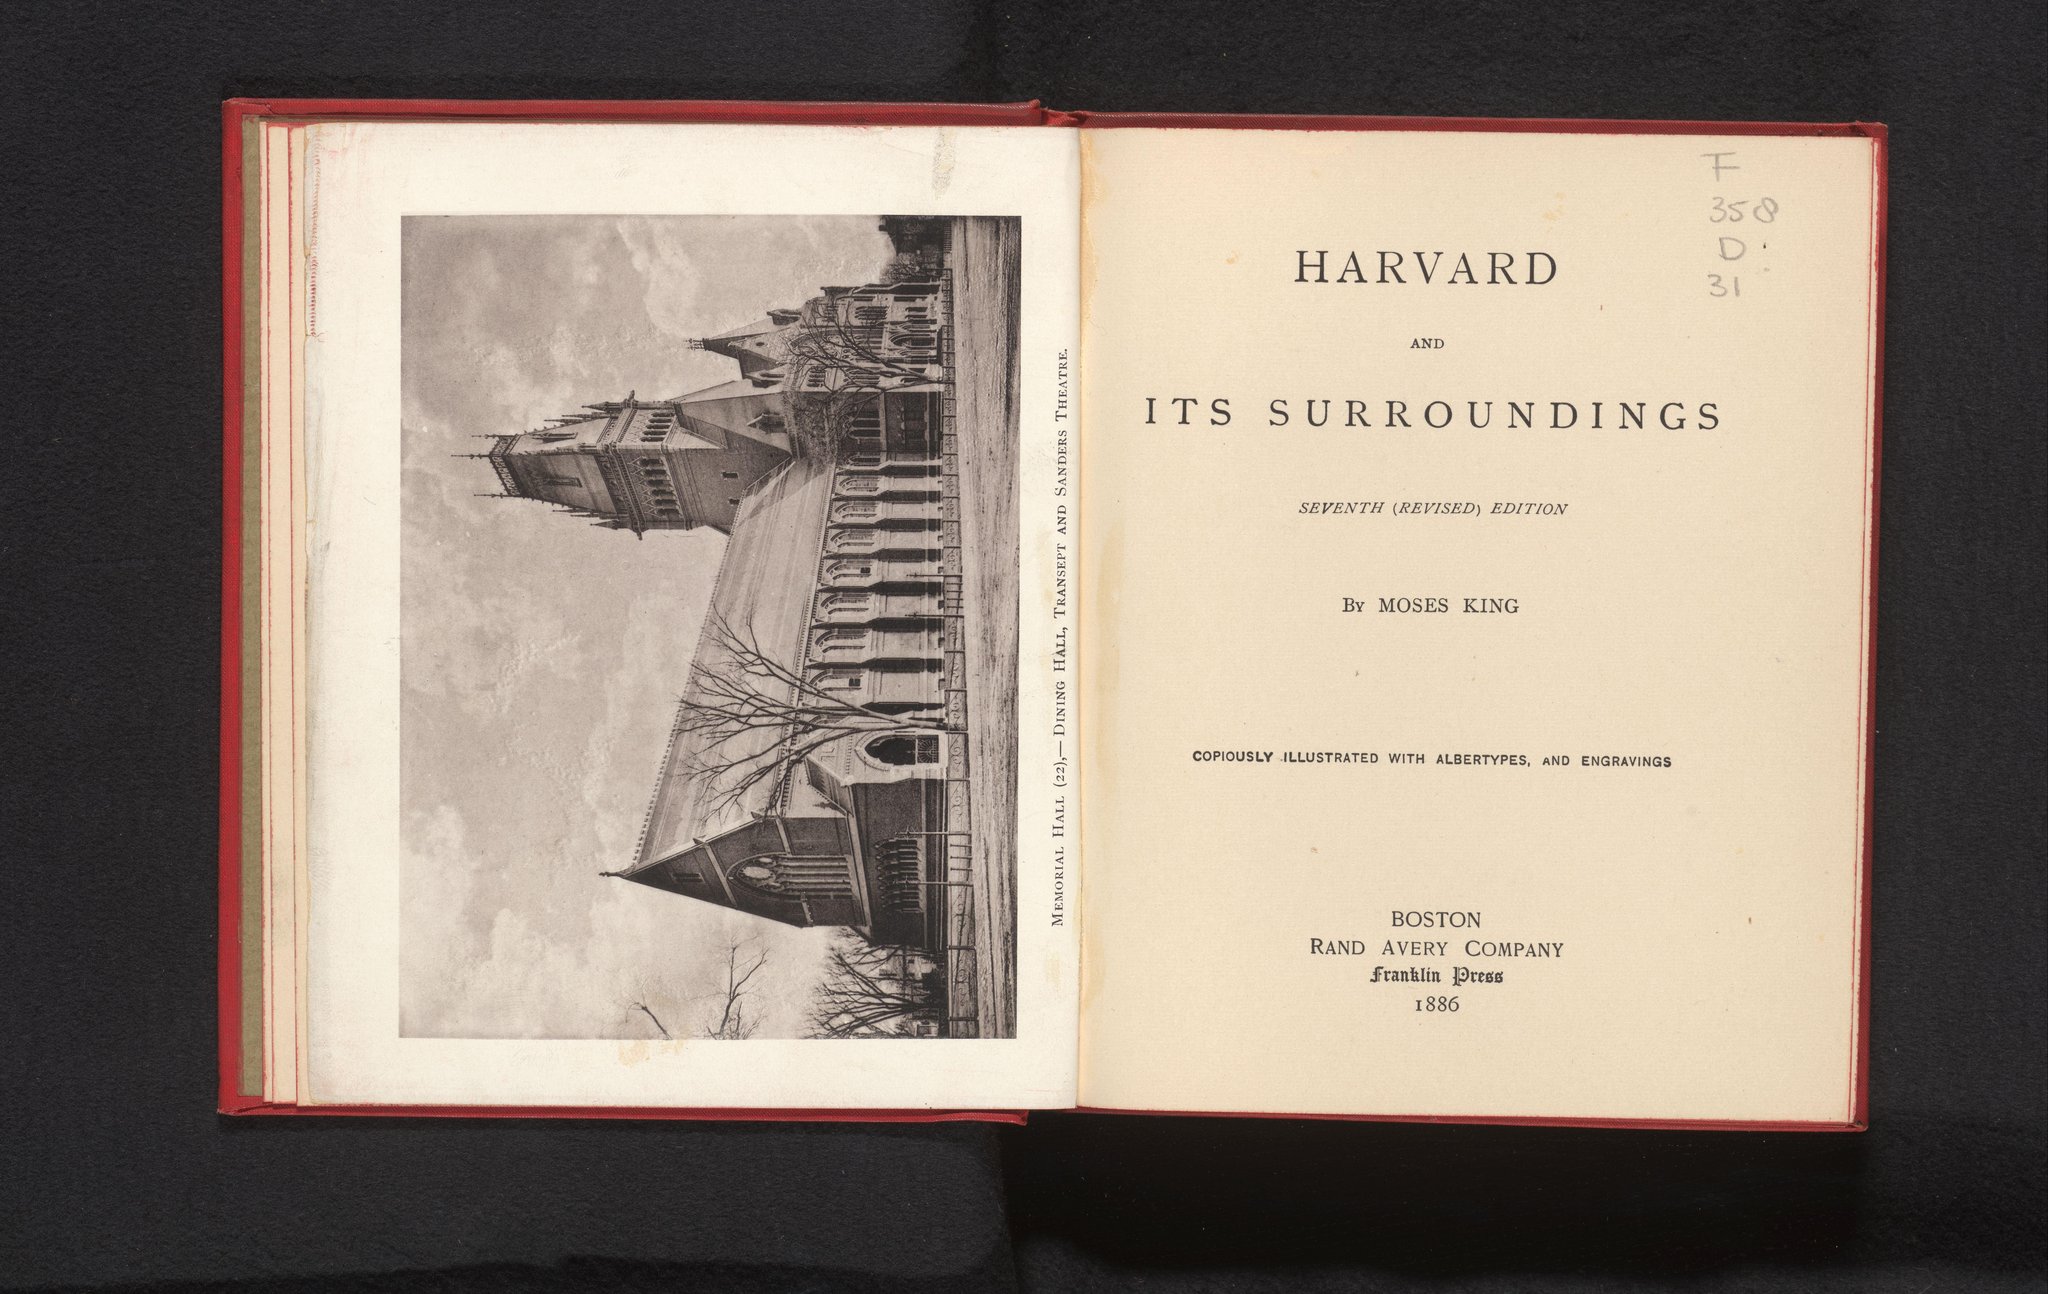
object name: page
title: Memorial Hall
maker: Anonymous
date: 1881-1886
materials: paper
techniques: photograph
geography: cambridge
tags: university building, college, façade (of house or building)